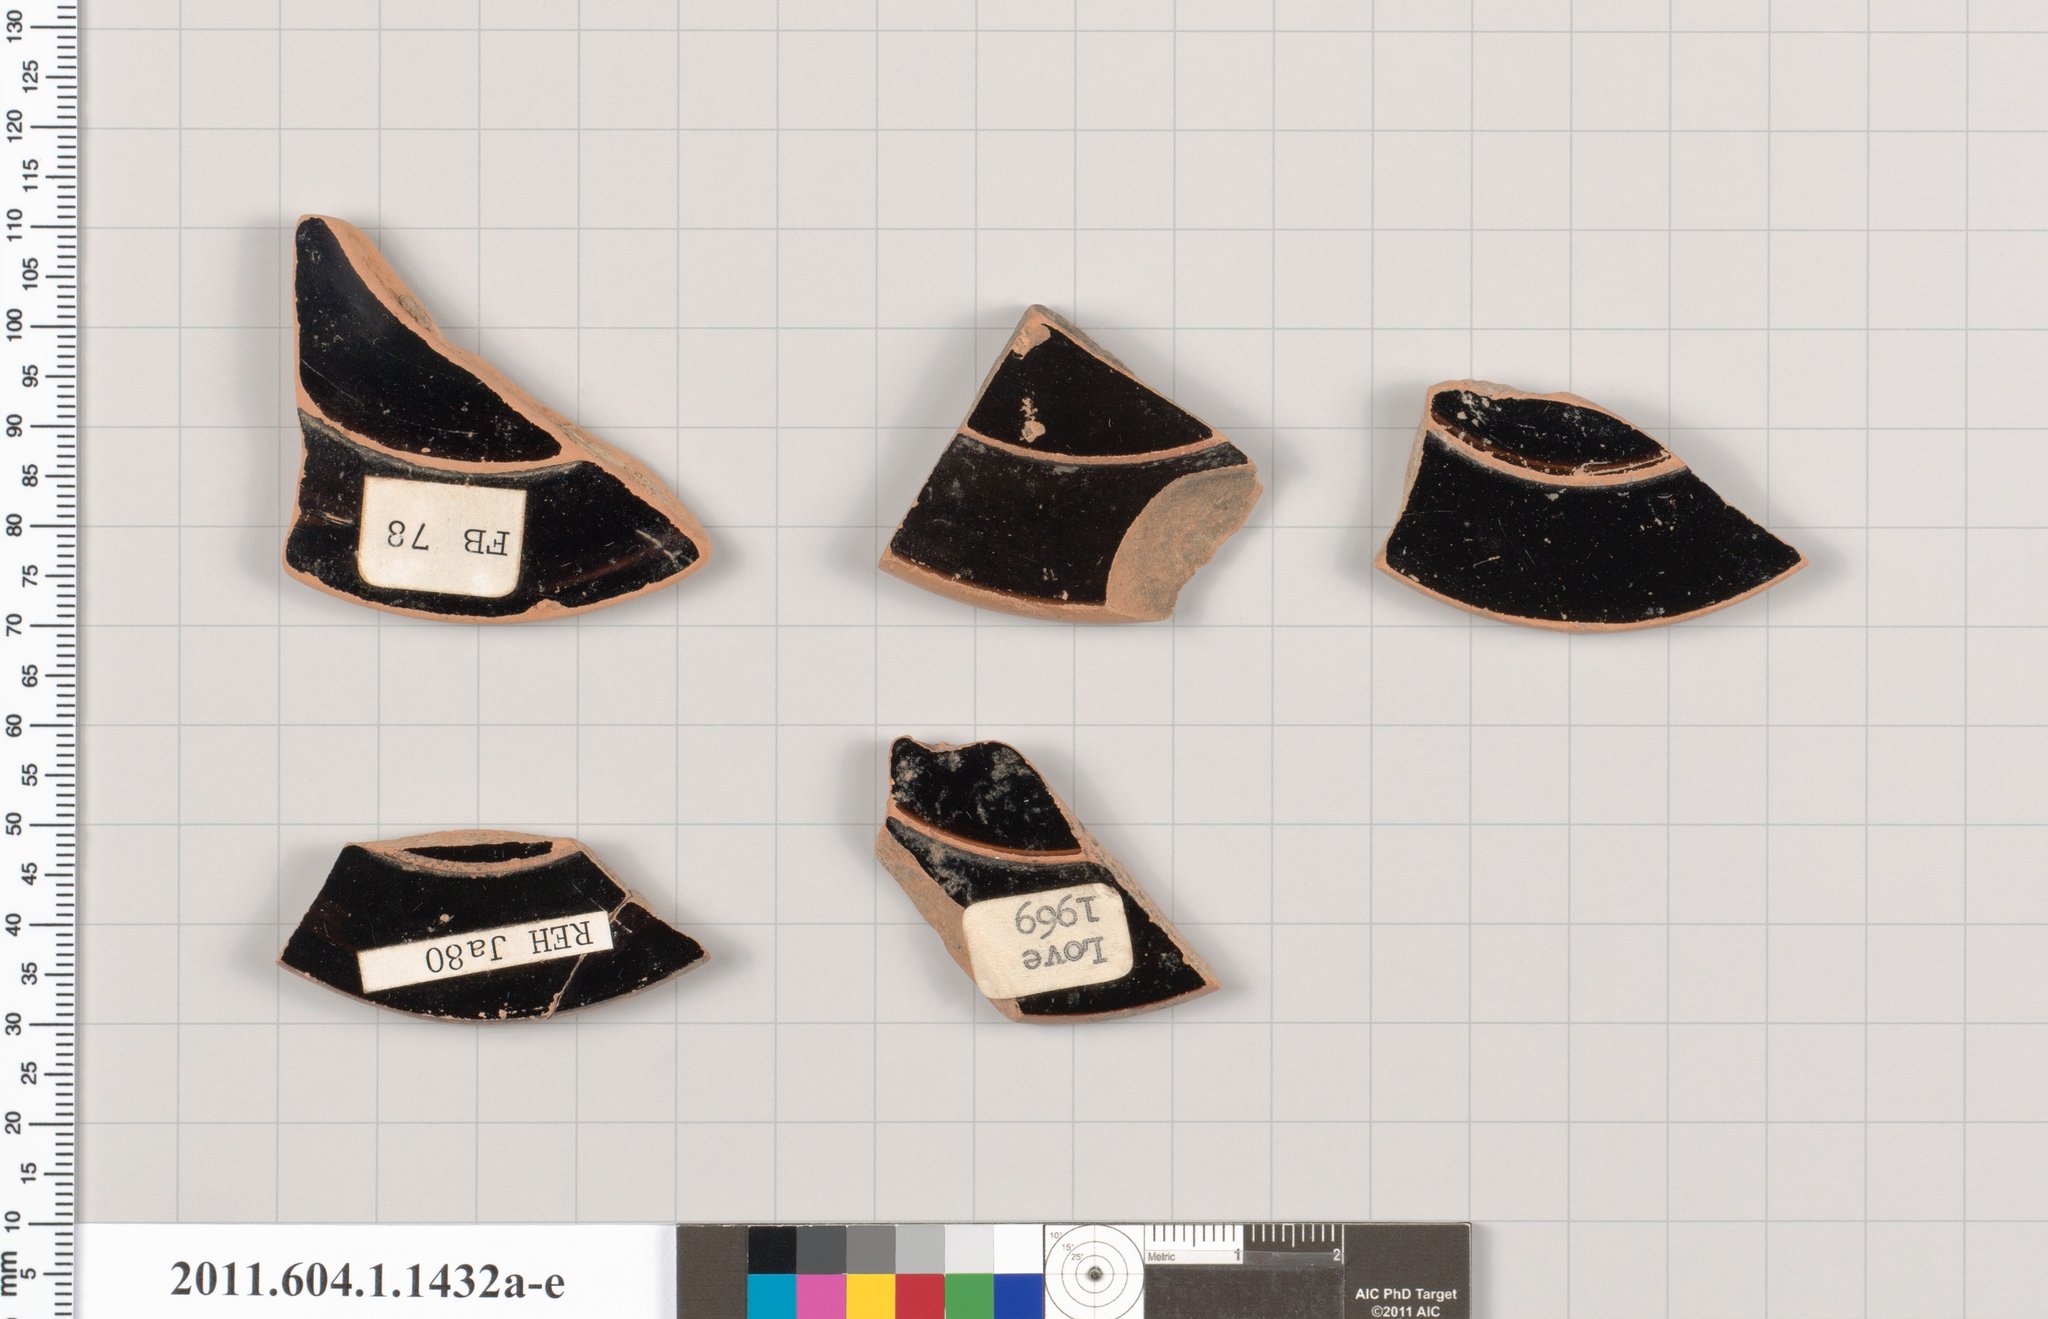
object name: kylix fragment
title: Terracotta fragments of kylikes (drinking cups)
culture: greek, attic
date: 500-401 BCE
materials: terracotta